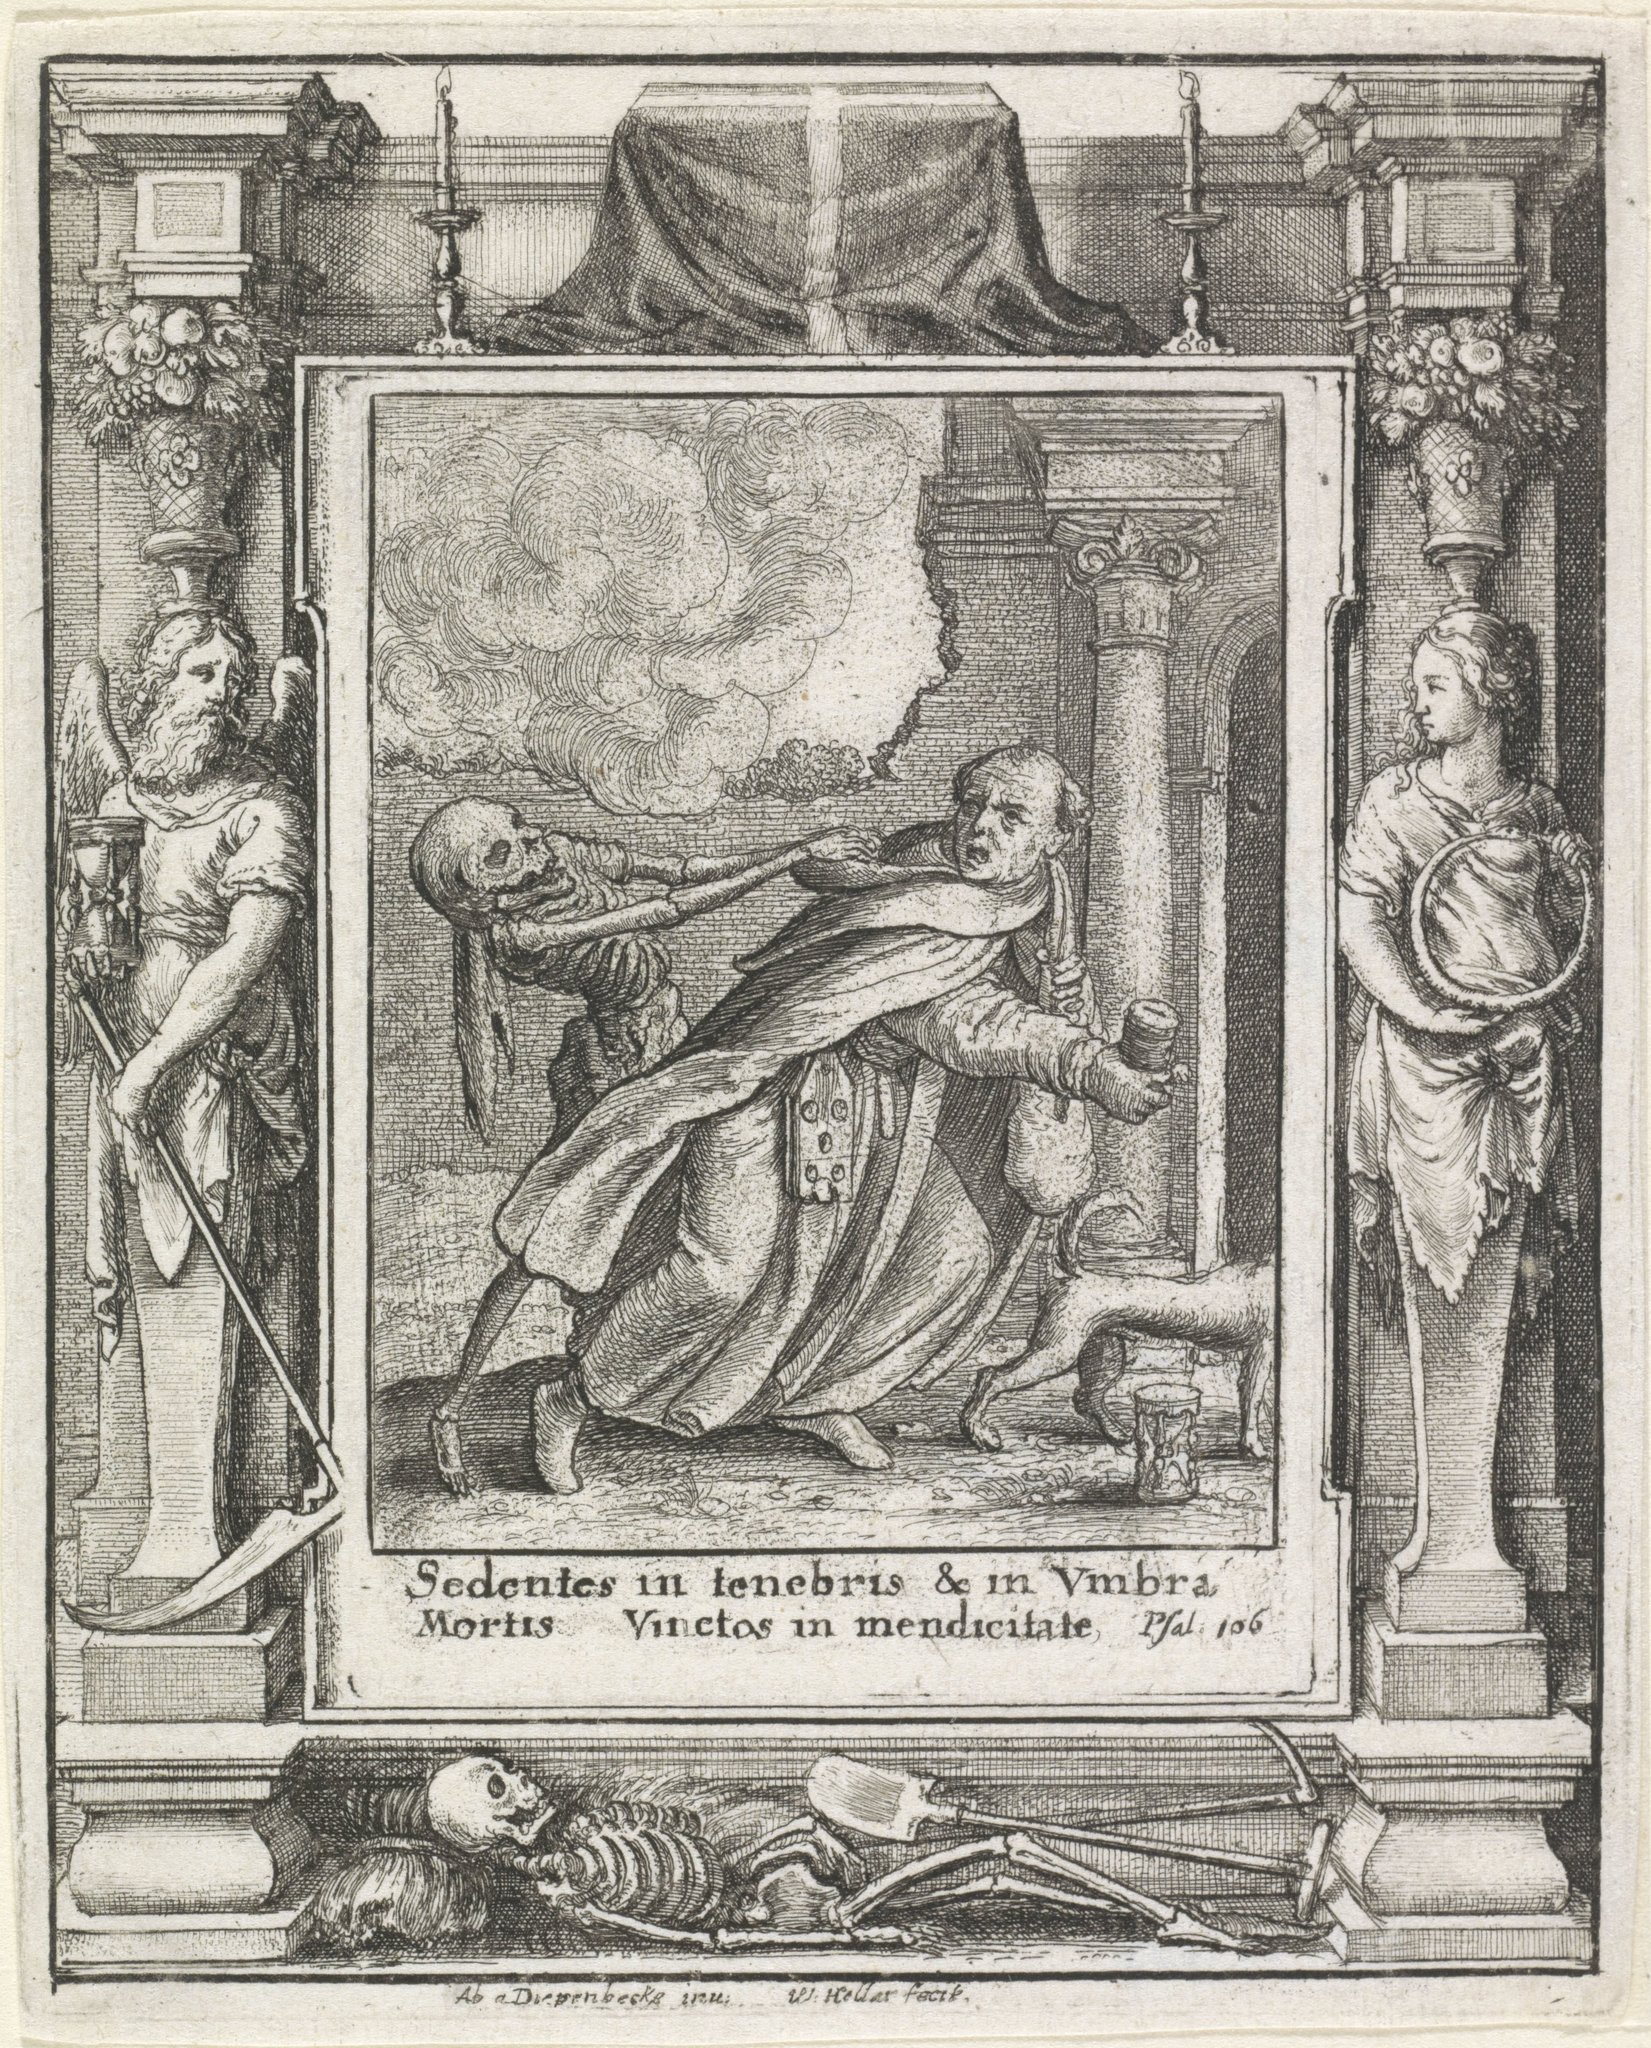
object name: print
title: Dodendans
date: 1651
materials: paper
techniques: etching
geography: antwerp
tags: dance of death; death together with one or more human beings, eternity, 'aeternitas'; 'eternità','eternità o perpetuità' (ripa), book, father time, man with wings and scythe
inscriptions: collector's mark: Lugt 2228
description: De Dood trekt de monnik aan zijn kapje. Vijftiende prent uit een reeks van 30 dodendansprenten; met een omlijsting met Vader Tijd en Eeuwigheid.